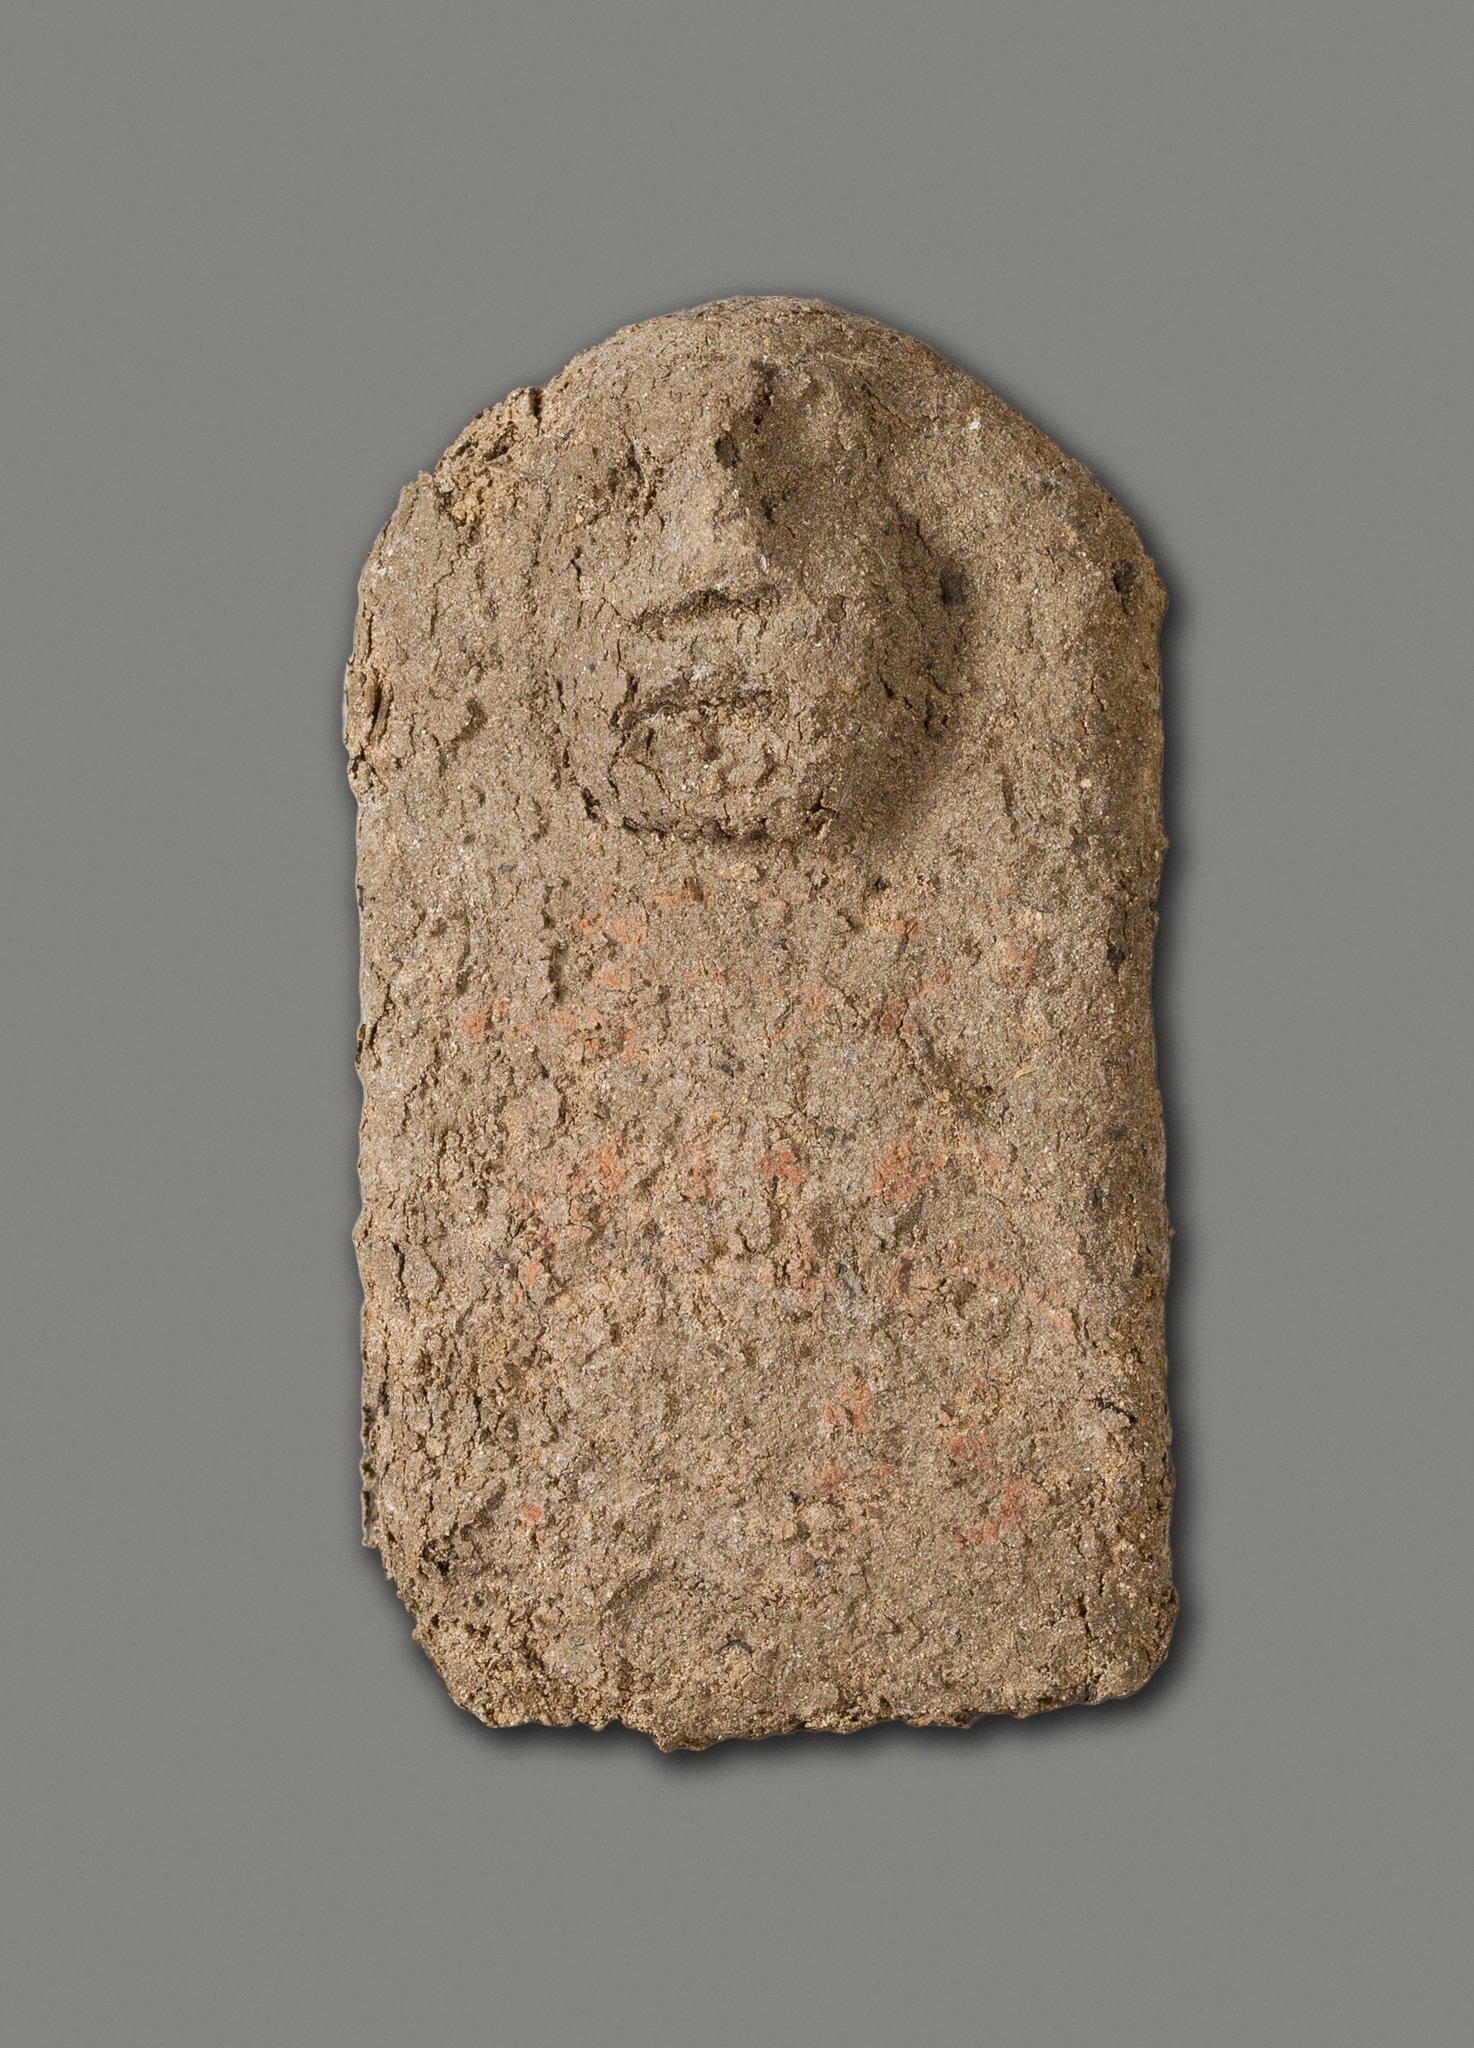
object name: figure, magical, execration, tablet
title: Magical Figure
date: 1802-1550 BCE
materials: clay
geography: egypt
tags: faces